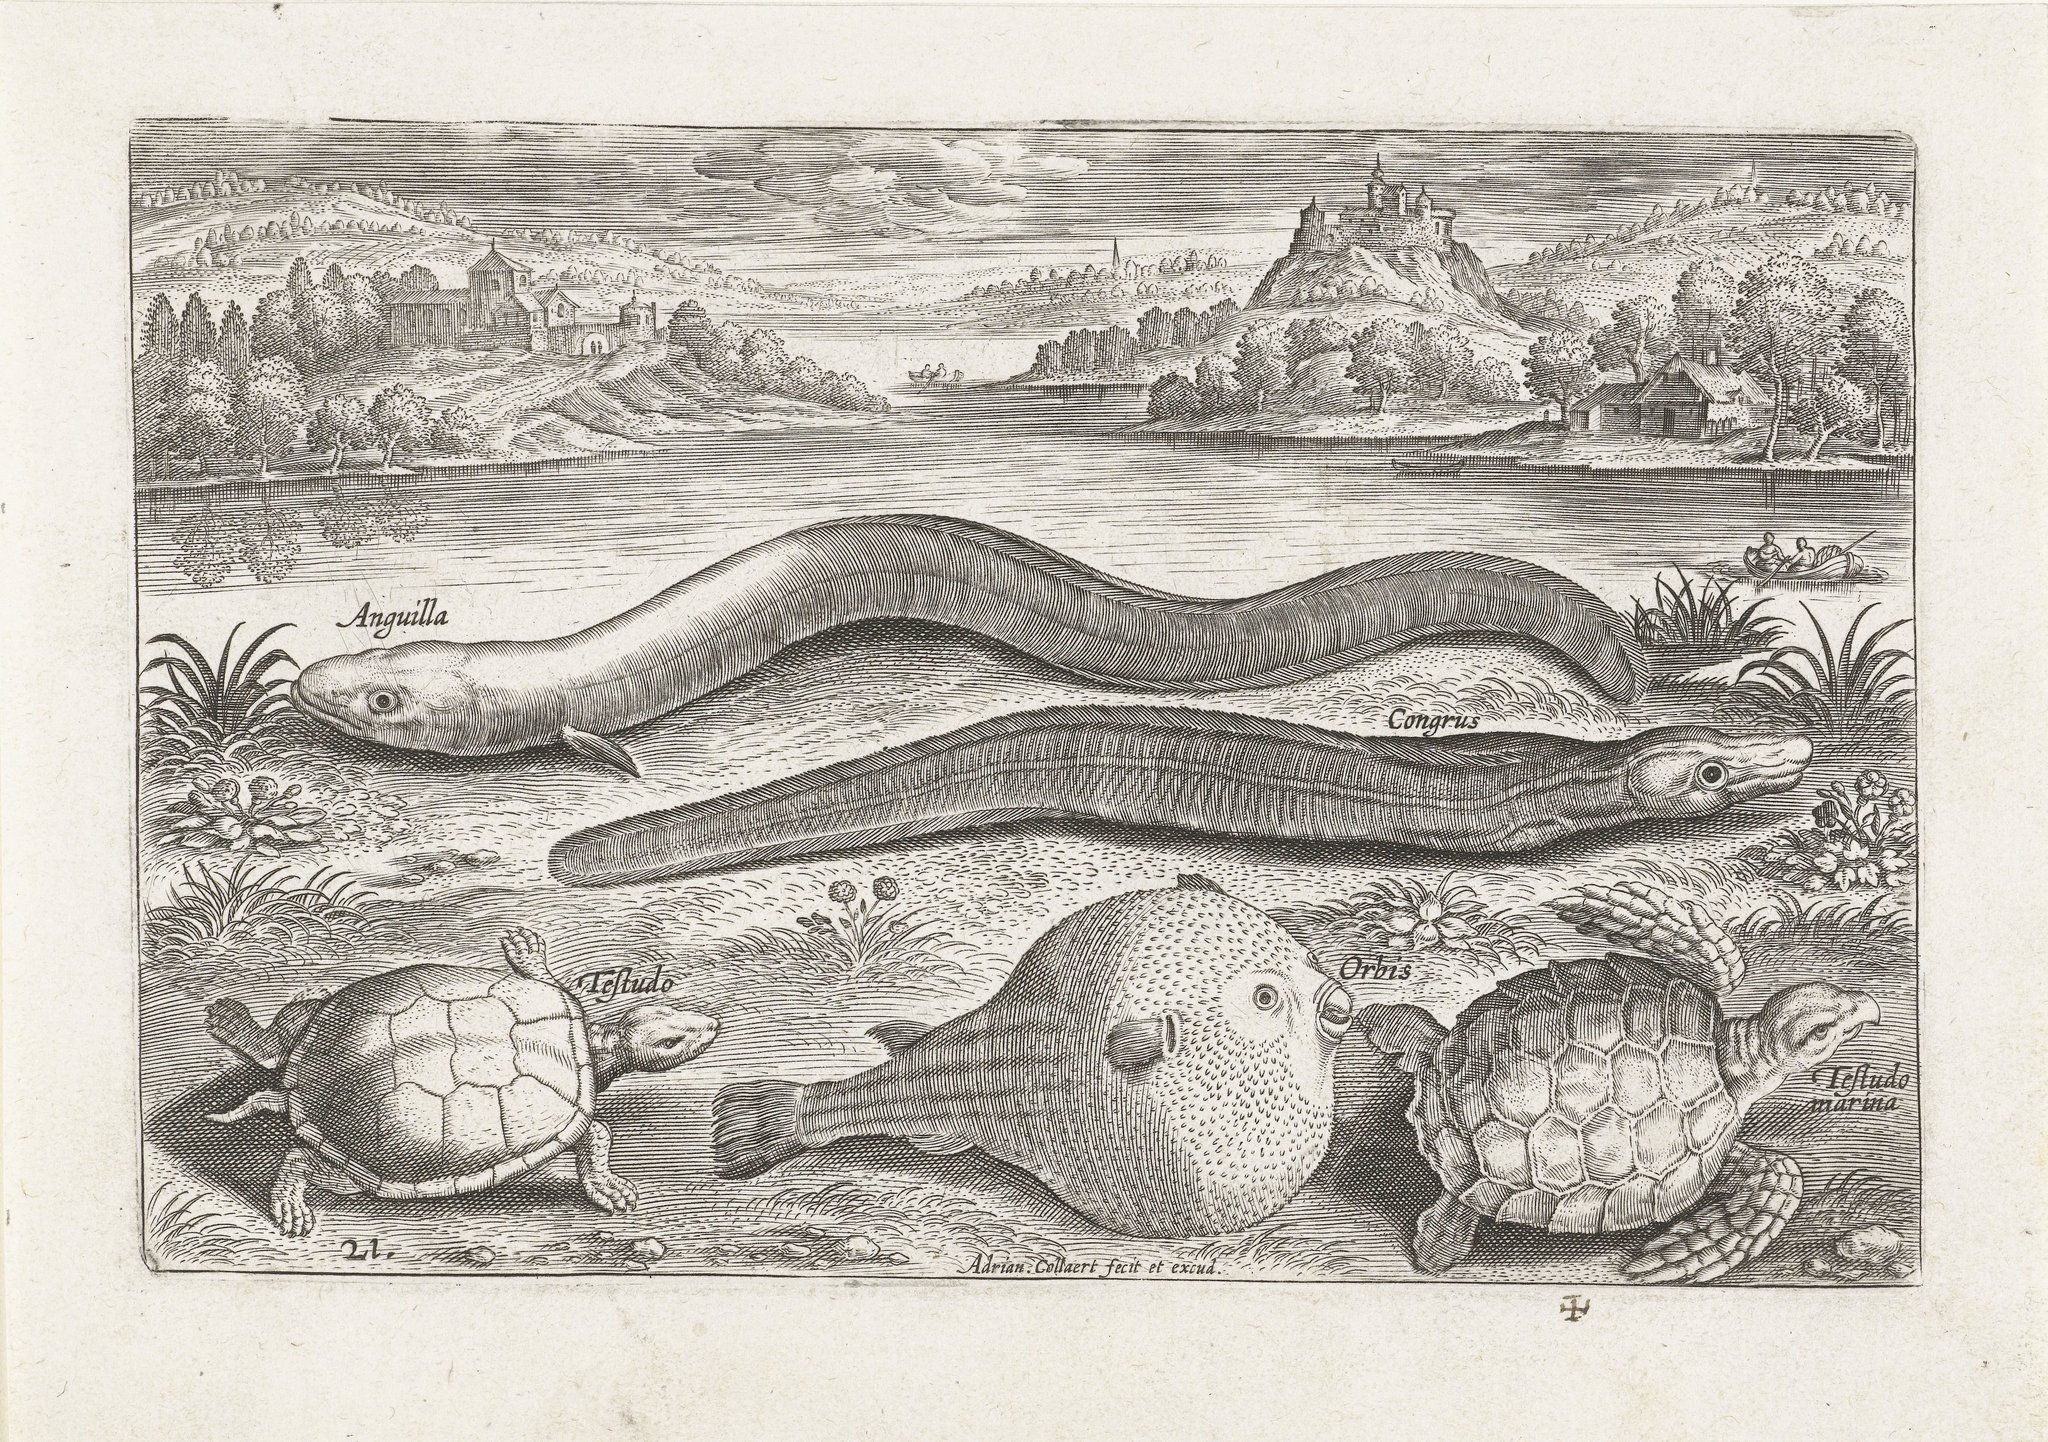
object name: print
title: Enkele schildpadden en vissen op een oever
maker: adriaen collaert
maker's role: draughtsman, print maker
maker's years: 1560-1618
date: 1598-1618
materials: paper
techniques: engraving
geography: antwerp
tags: tortoises, turtles, river, eels: eel, bony fishes: blowfish, eels: conger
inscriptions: collector's mark: Lugt 2228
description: Twee schildpadden, een aal, een paling en een kogelvis liggen samen op de oever van een rivier. Op de achtergrond de rivier. De prent maakt deel uit van een serie met vissen als onderwerp.